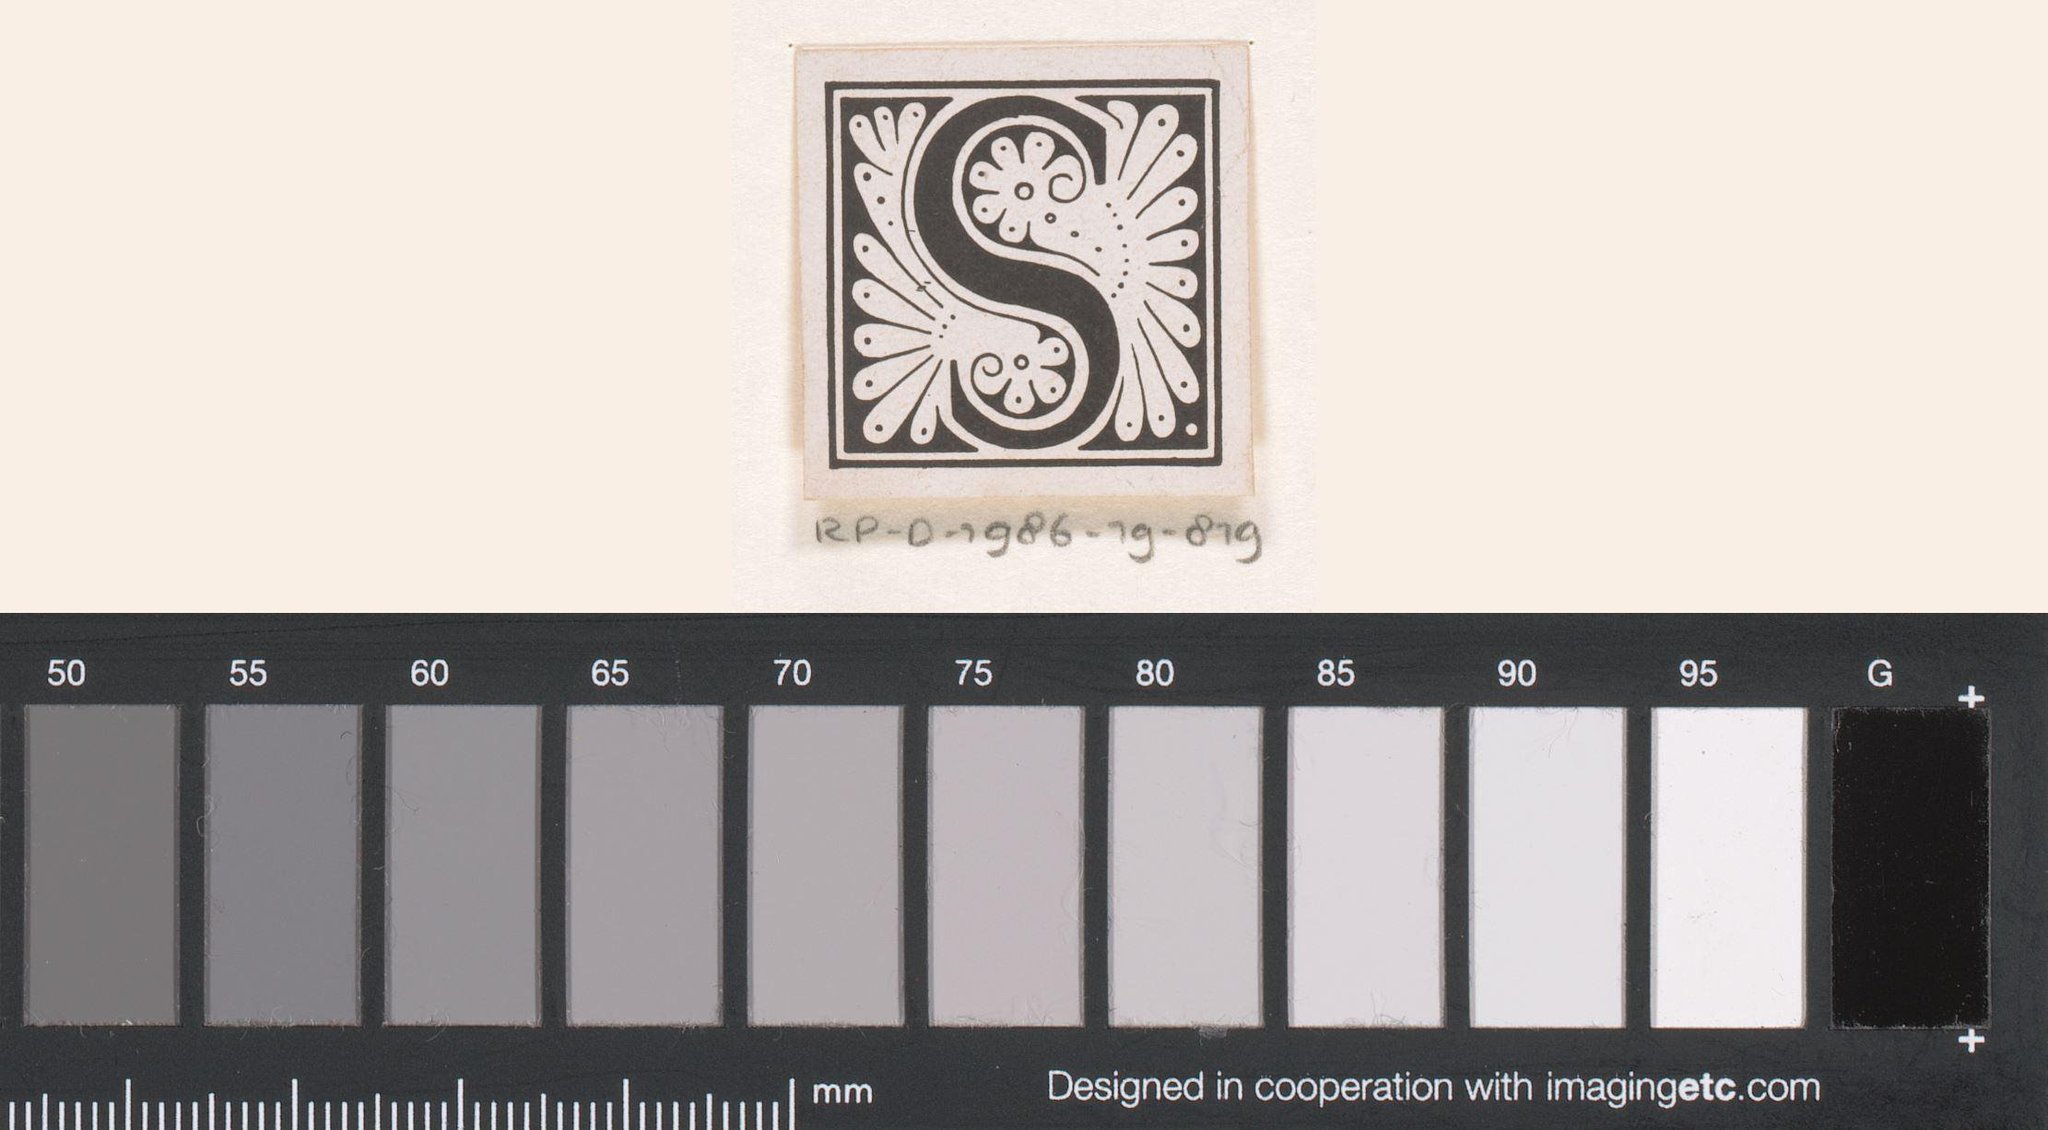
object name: photomechanical print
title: Initiaal S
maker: reinier willem petrus de vries (1874-1953)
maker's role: draughtsman, print maker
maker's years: 1874-1953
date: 1904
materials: paper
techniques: printing block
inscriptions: collector's mark: ‘R:MVS.’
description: Het initiaal is gebruikt voor: Veth, Jan. Jozef Israëls en zijn kunst. Arnhem en Nijmegen: Gebroeders E&M Cohen, 1904.